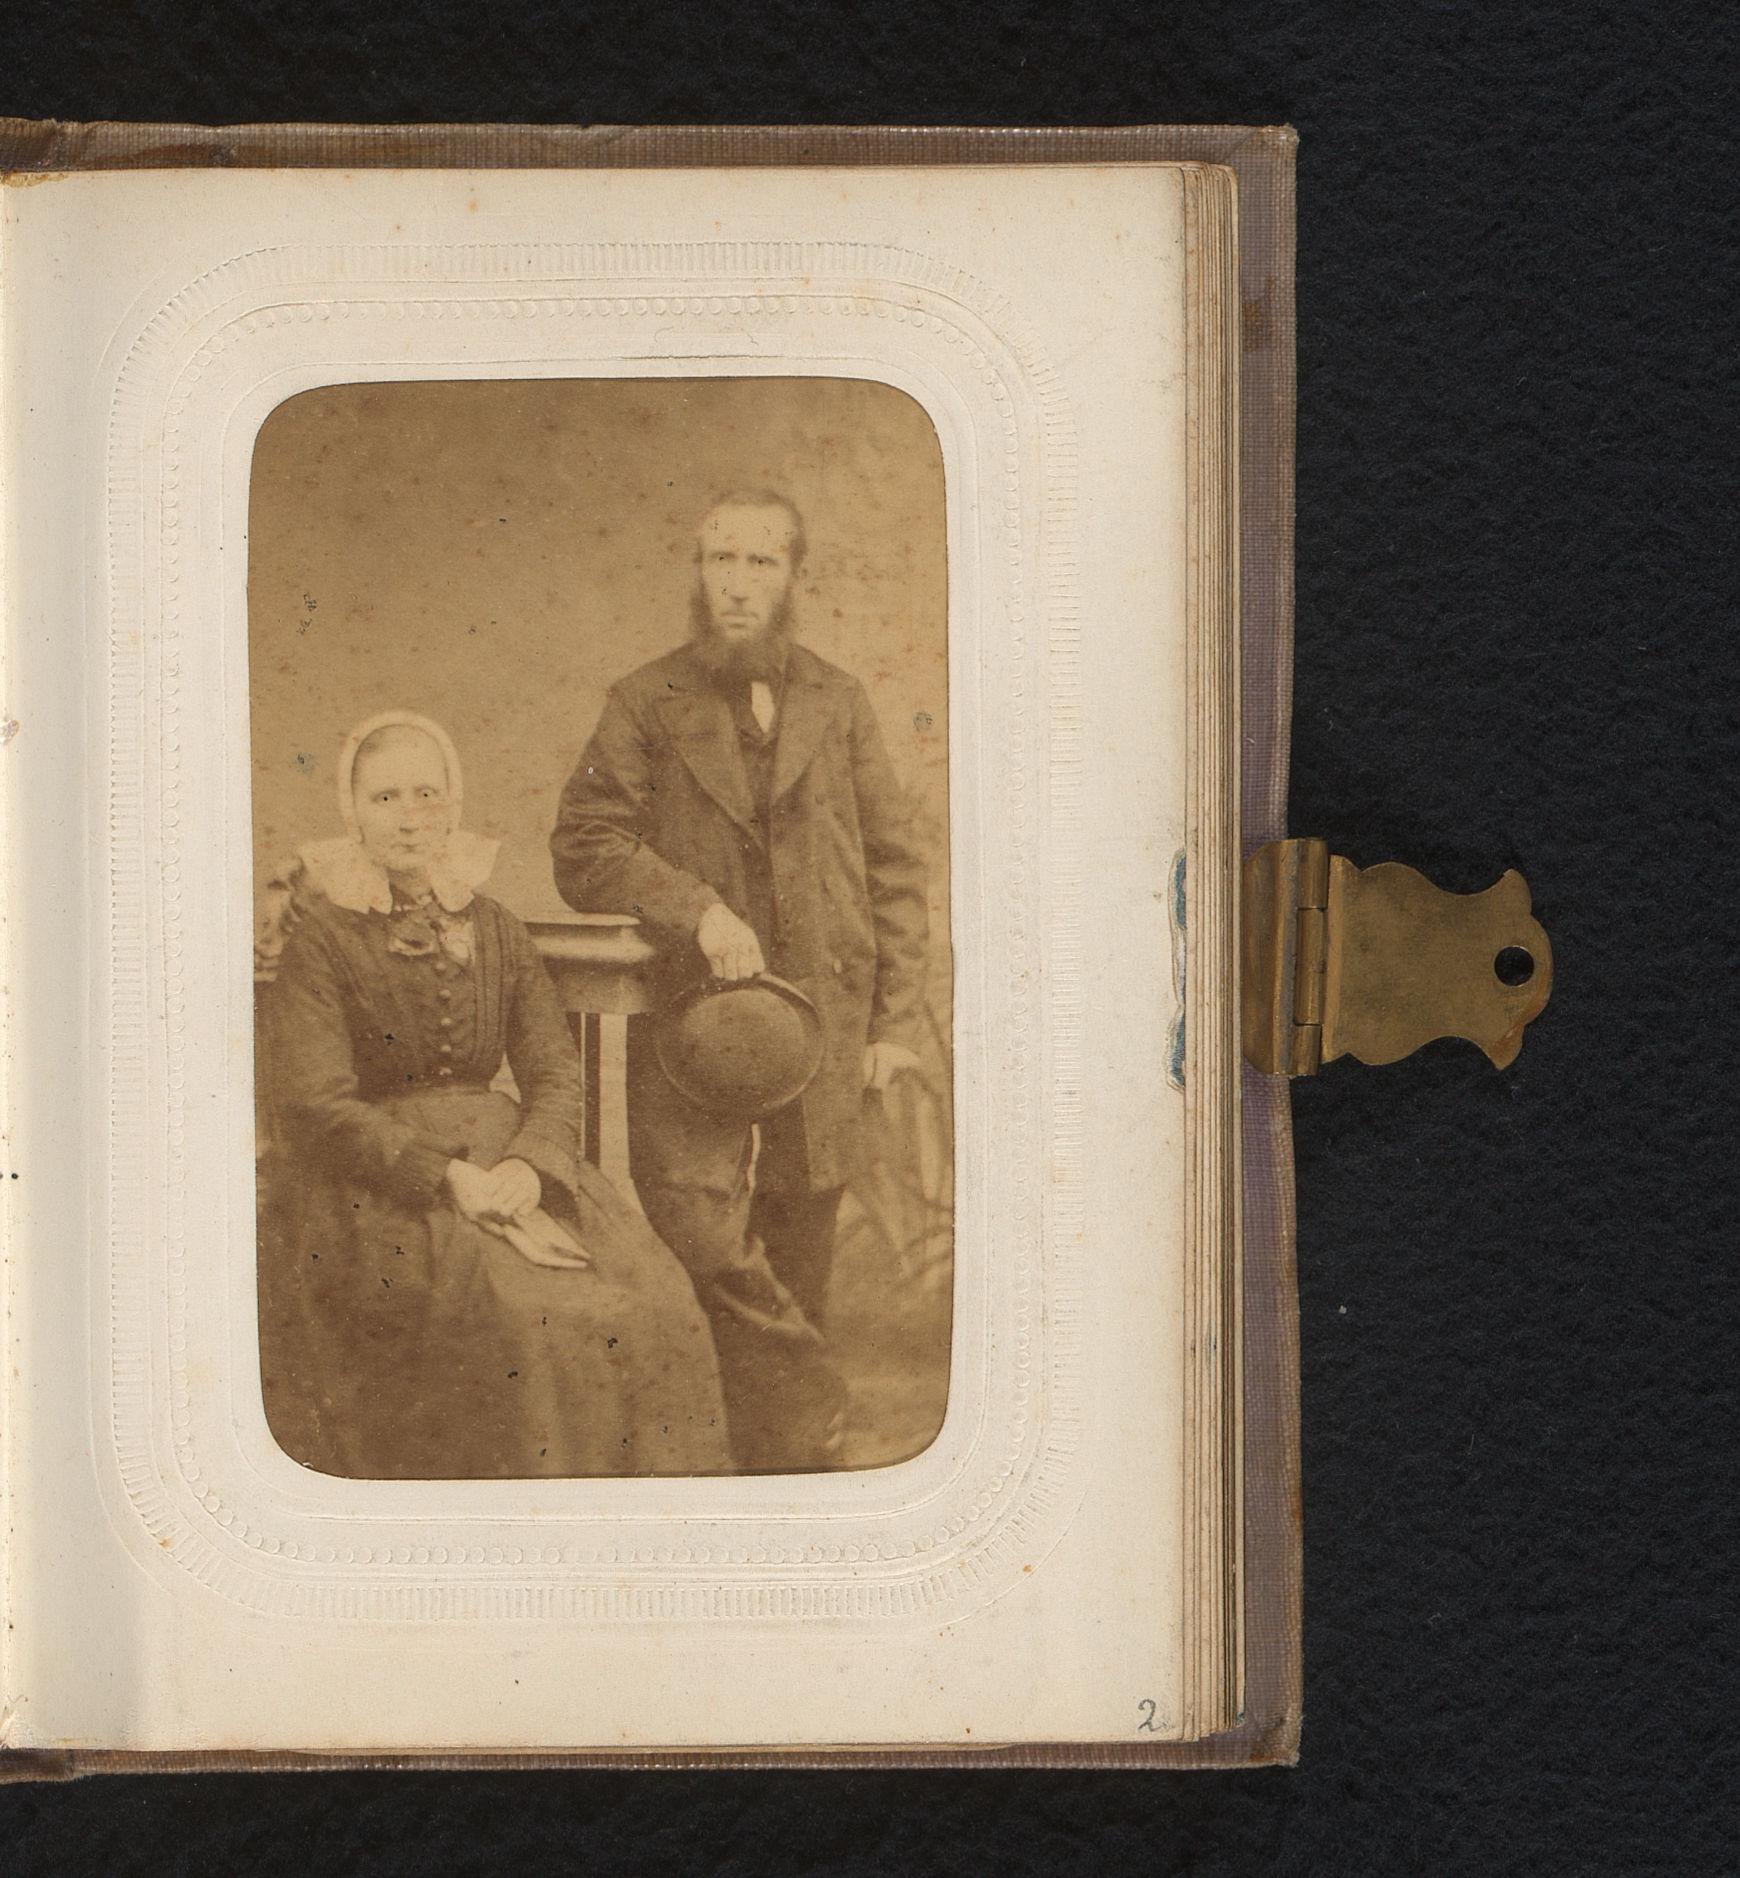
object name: album leaf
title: Portret van een staande man met hoed in de hand en een zittende vrouw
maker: g.c. hubers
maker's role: fotograaf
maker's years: 1814-1884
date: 1869-1884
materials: cardboard, photographic support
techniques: albumen print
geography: deventer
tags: historical persons - bb - woman, historical persons, head-gear: hat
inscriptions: inscription: ‘Photographie/ INSTANTANÉ/ Firma/ G.C. Hubers/ Korte/ Zandstraat/ DEVENTER/ Buiten de Noordenberg.’